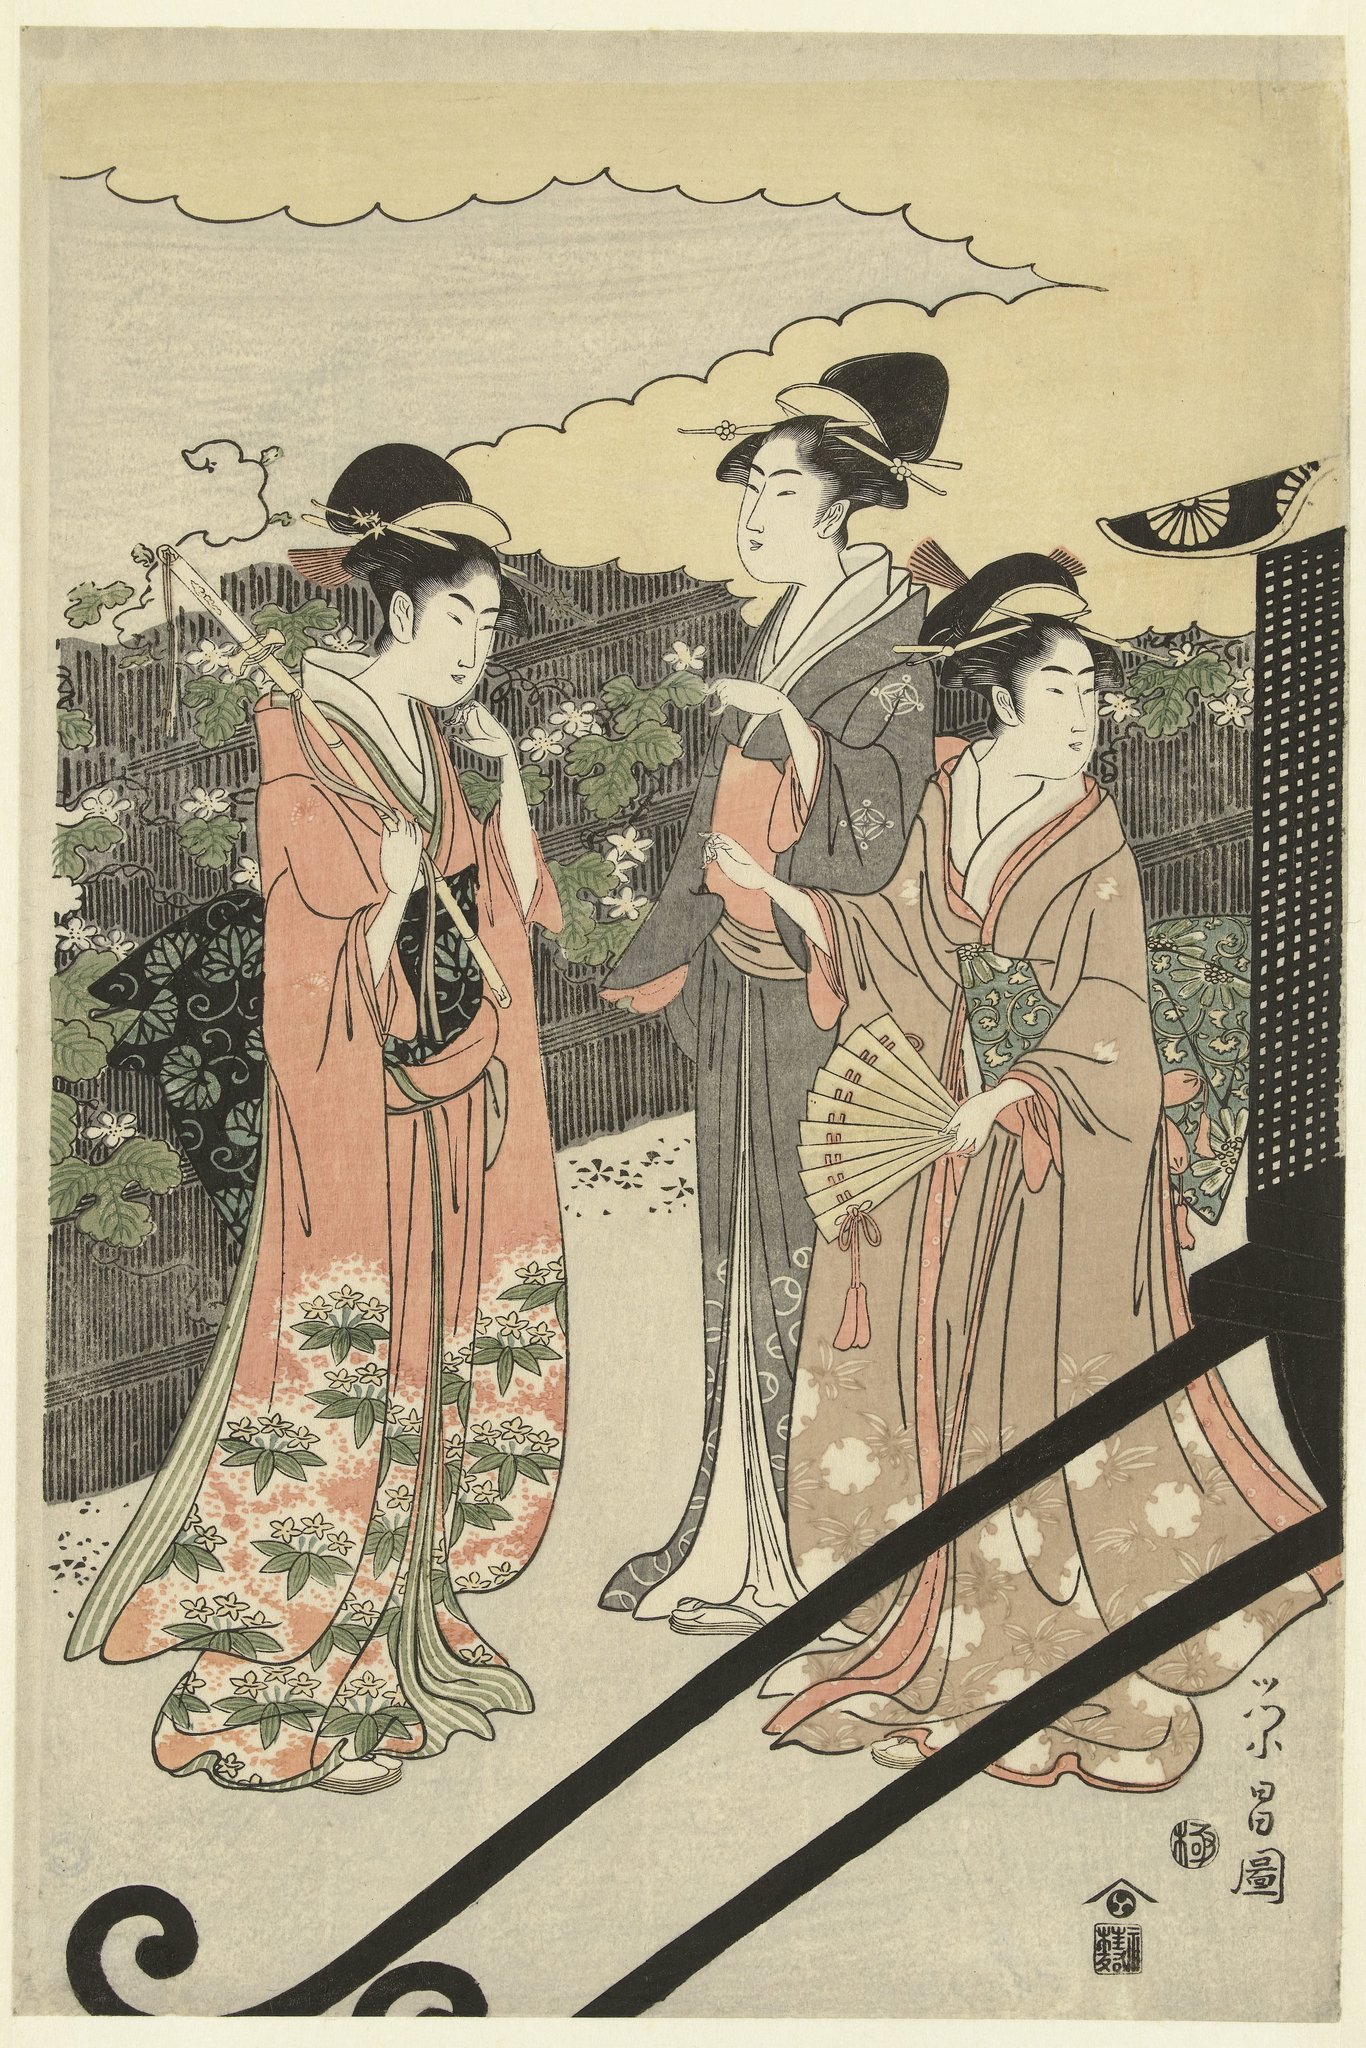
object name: print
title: Prins Genji en Yugao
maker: chokosai eishô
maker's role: print maker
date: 1795-1800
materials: paper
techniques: woodcut, nishiki e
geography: tokyo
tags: fan, adult woman (+ three persons), passenger carriage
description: Drie vrouwen, één met zwaard een ander met waaier, staand tussen met bloeiende klimplant begroeid hek en rijtuig; onder geel wolkpatroon.